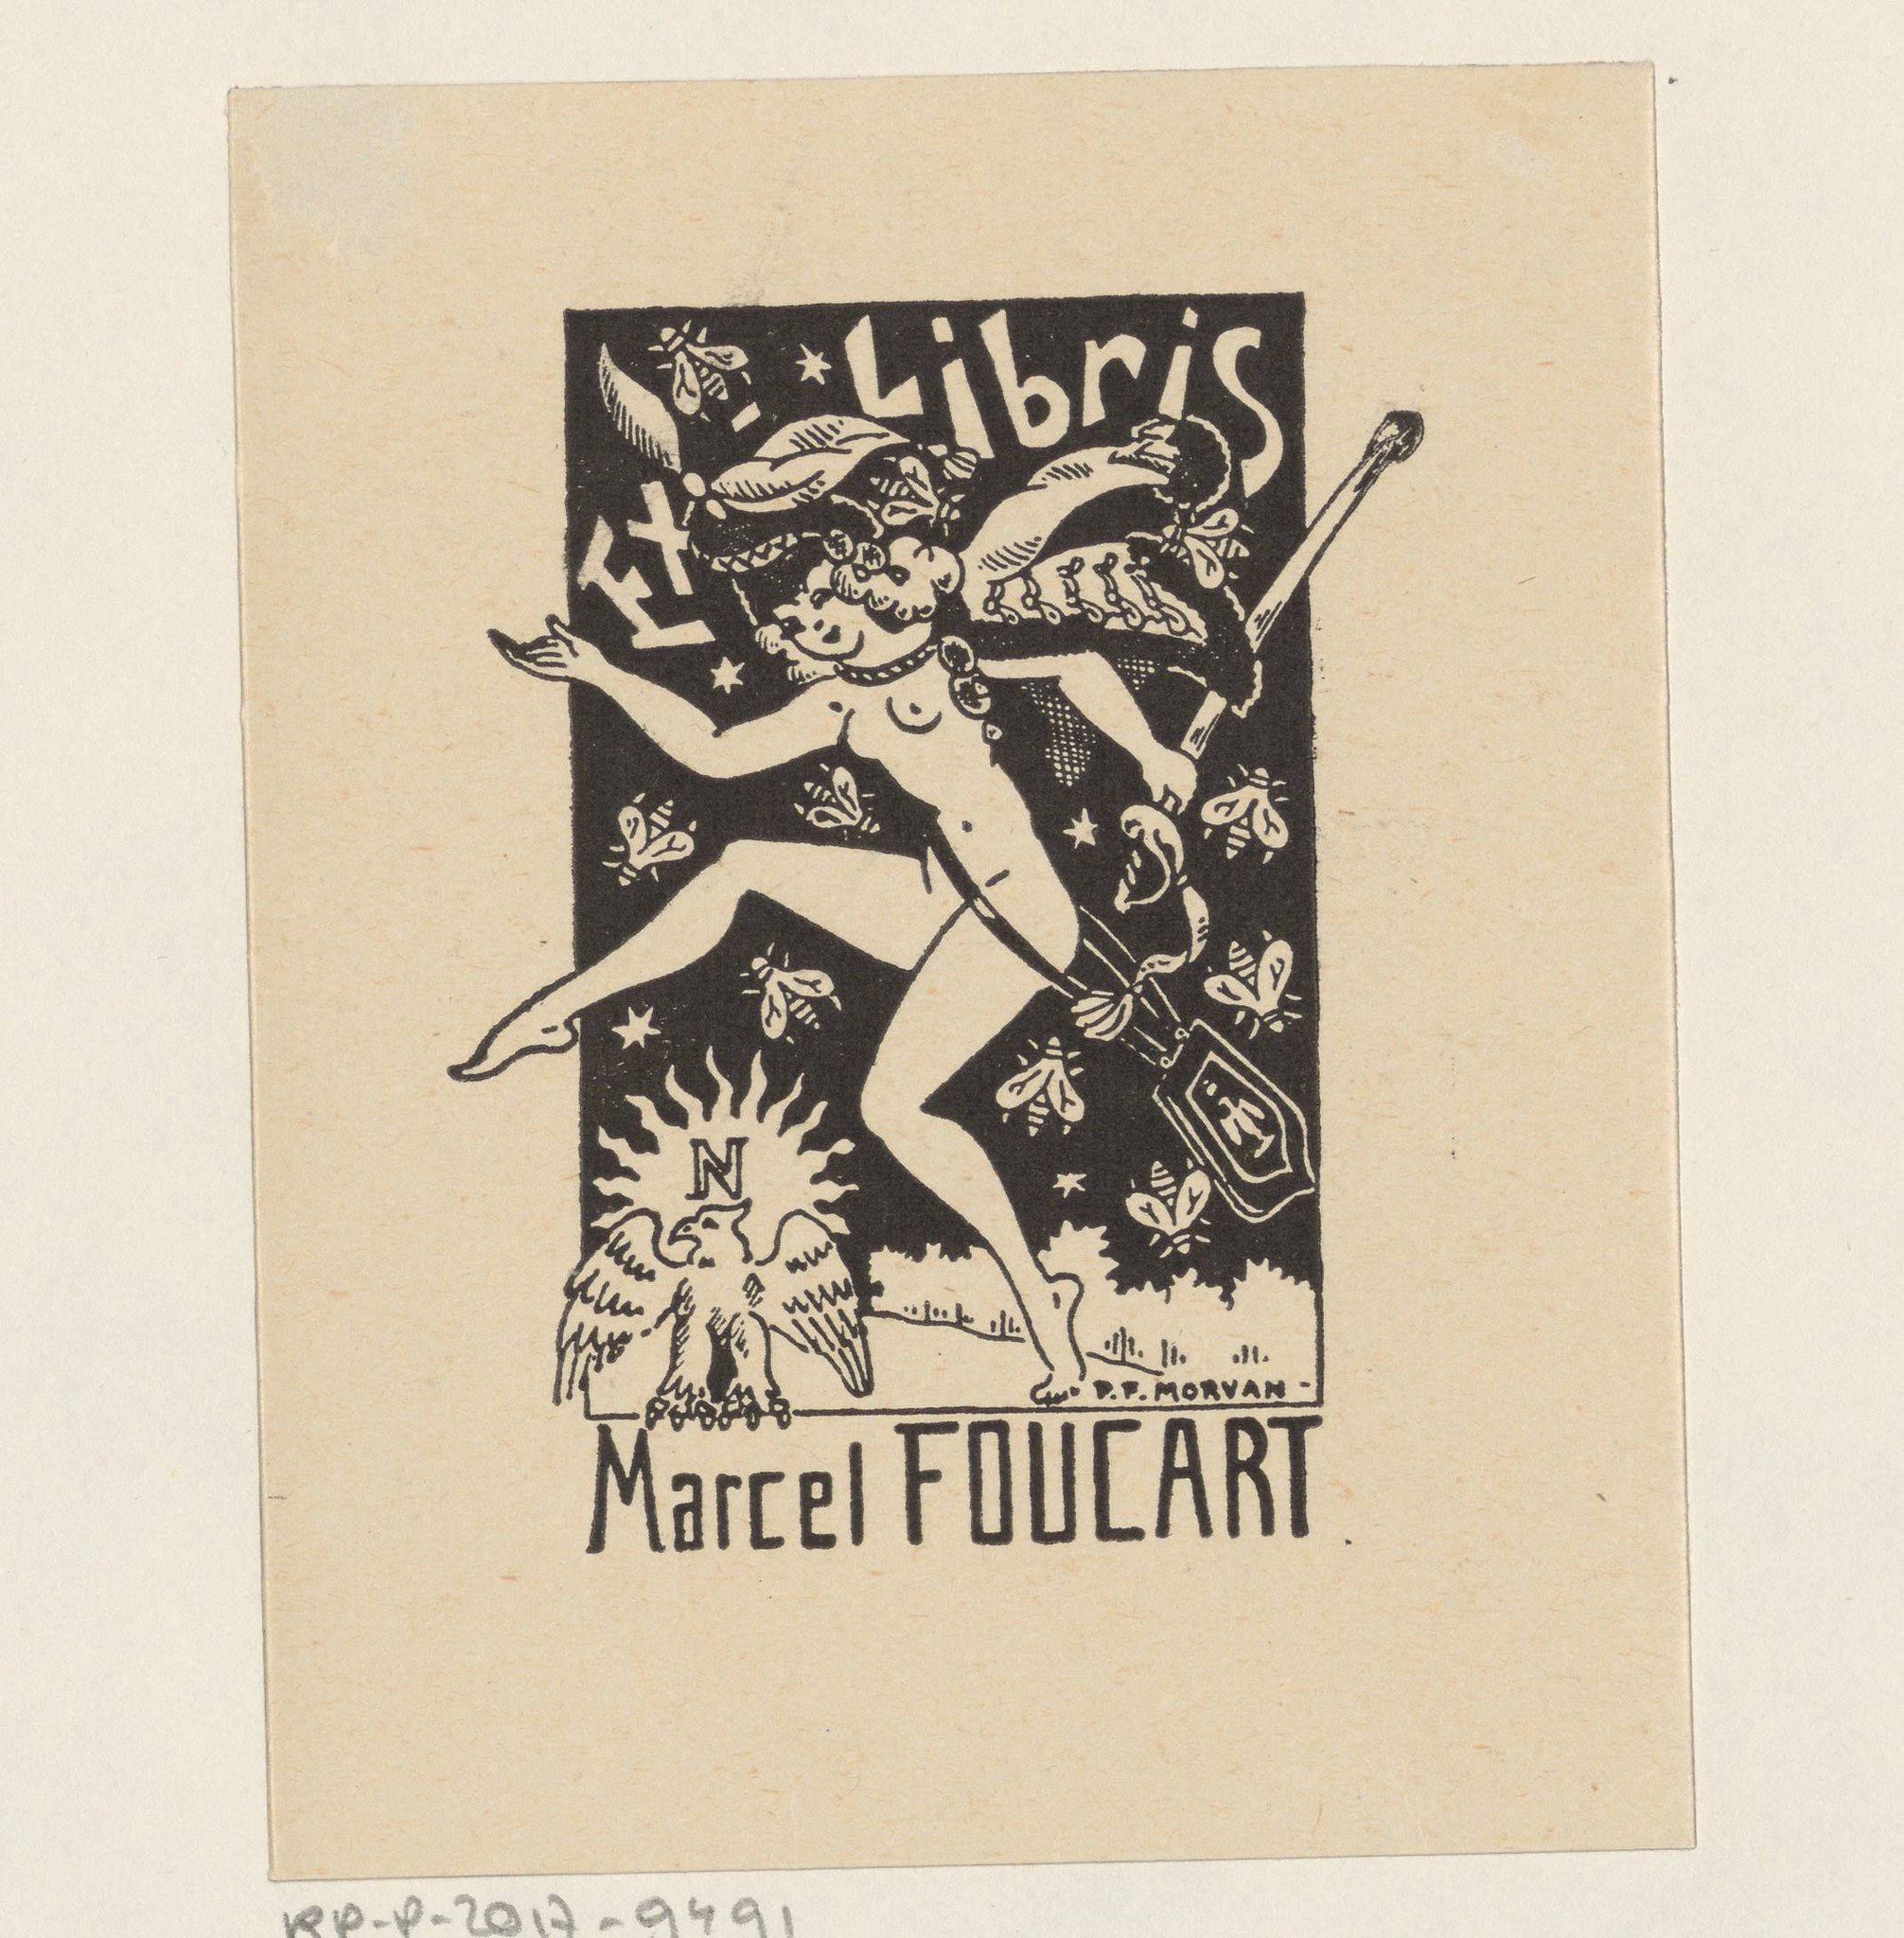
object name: bookplate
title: Ex libris van Marcel Foucart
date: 1900-1999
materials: paper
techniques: printing block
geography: france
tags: predatory birds: eagle, woman (showing herself) undressed, quasi-nude, insects: bee